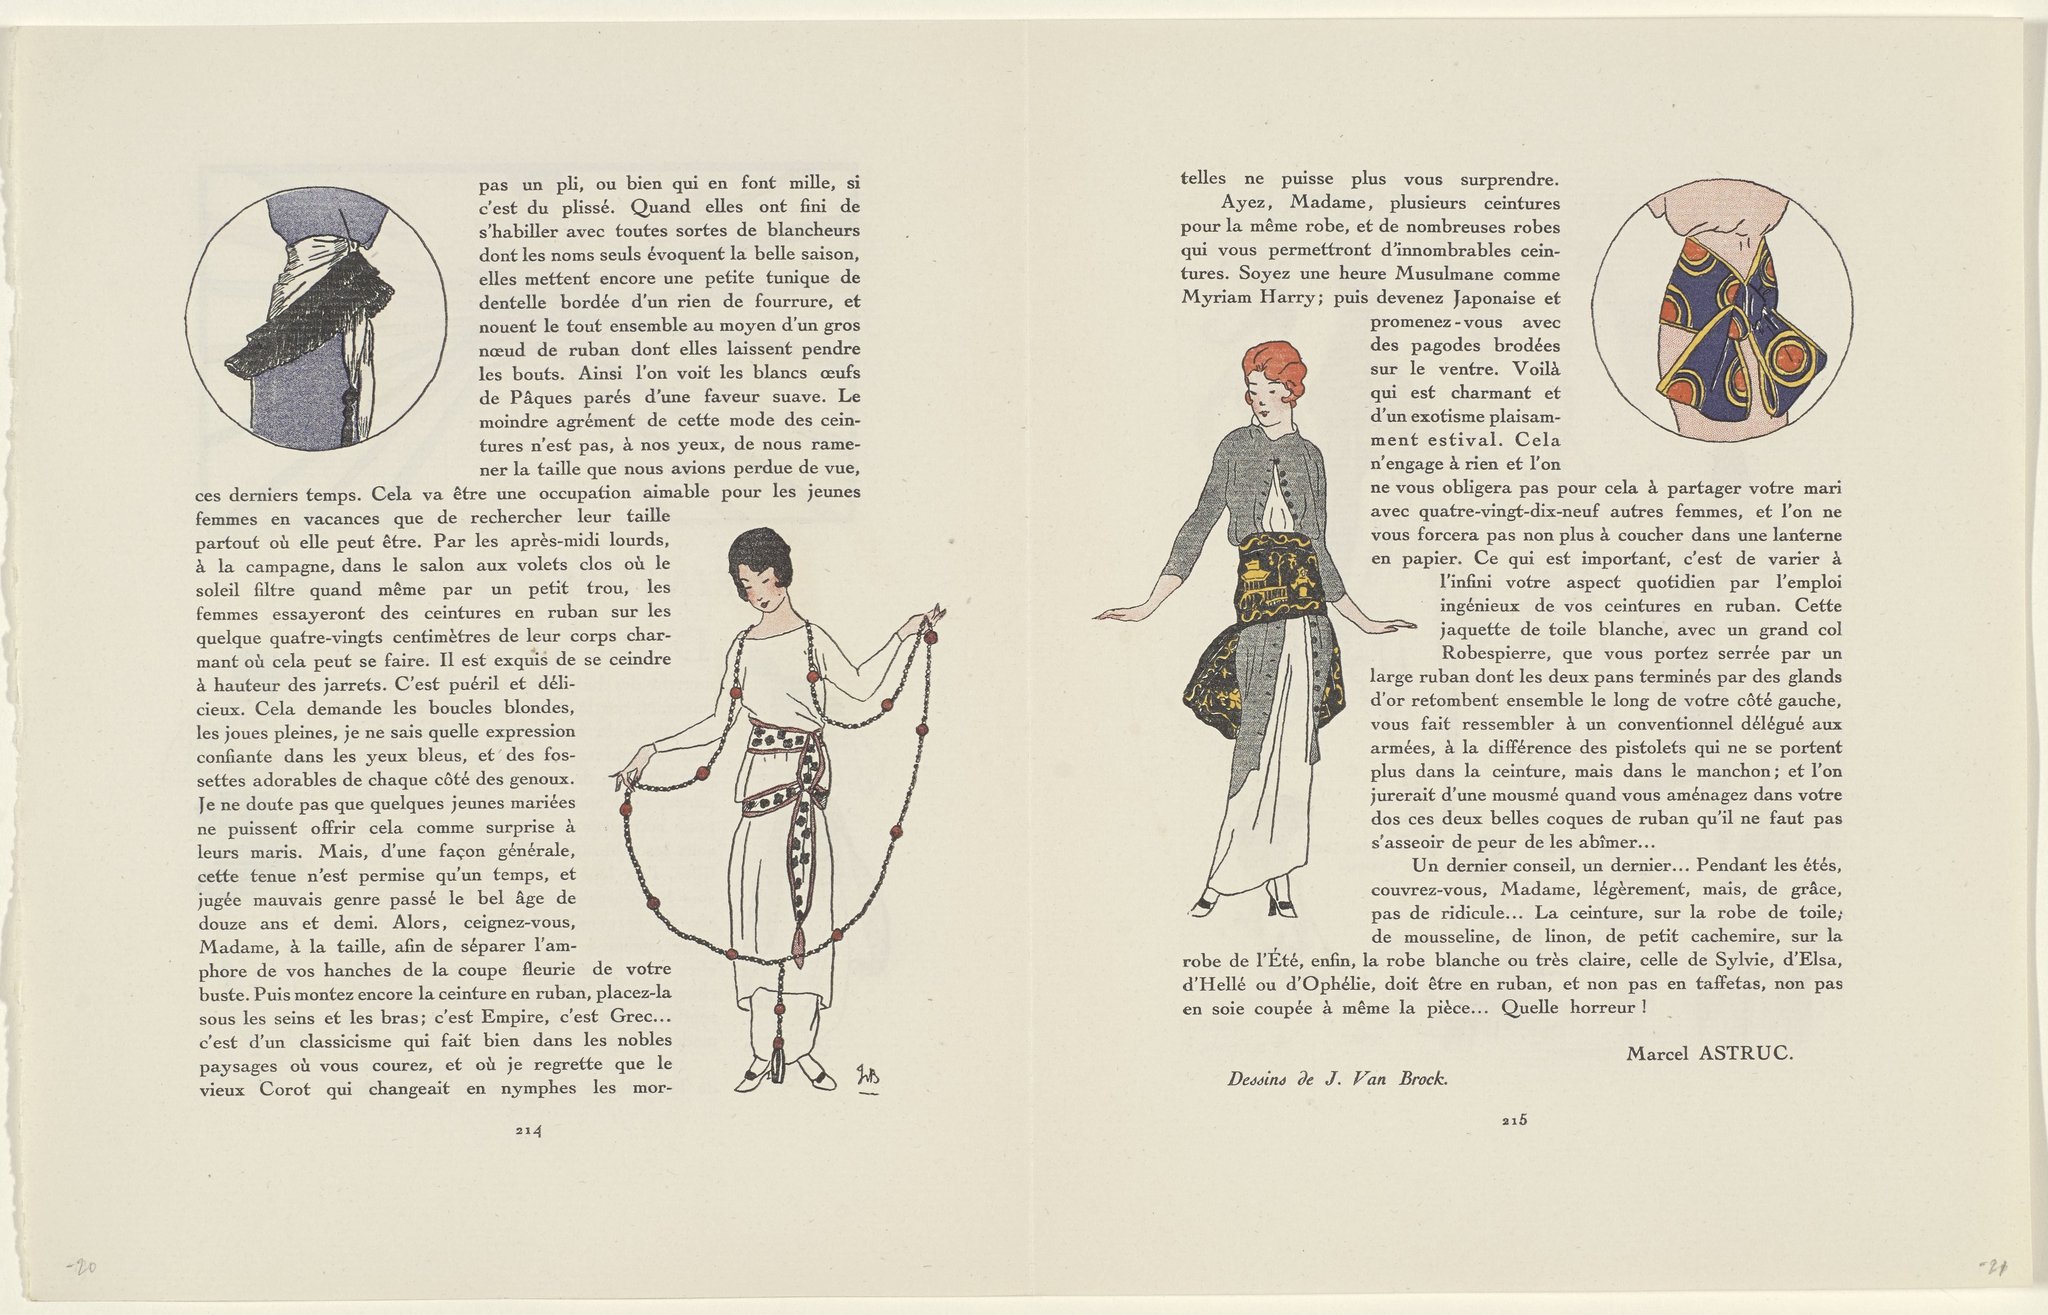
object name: fashion print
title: Gazette du Bon Ton, 1914 - No. 6, p. 214: Ceintures en ruban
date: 1914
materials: paper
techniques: letterpress printing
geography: paris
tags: fashion plates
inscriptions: date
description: Ceintures en ruban: tekst en illustraties: ensembles met ceintuurs. Pagina 214 in Gazette du Bon Ton, 1914 - No. 6